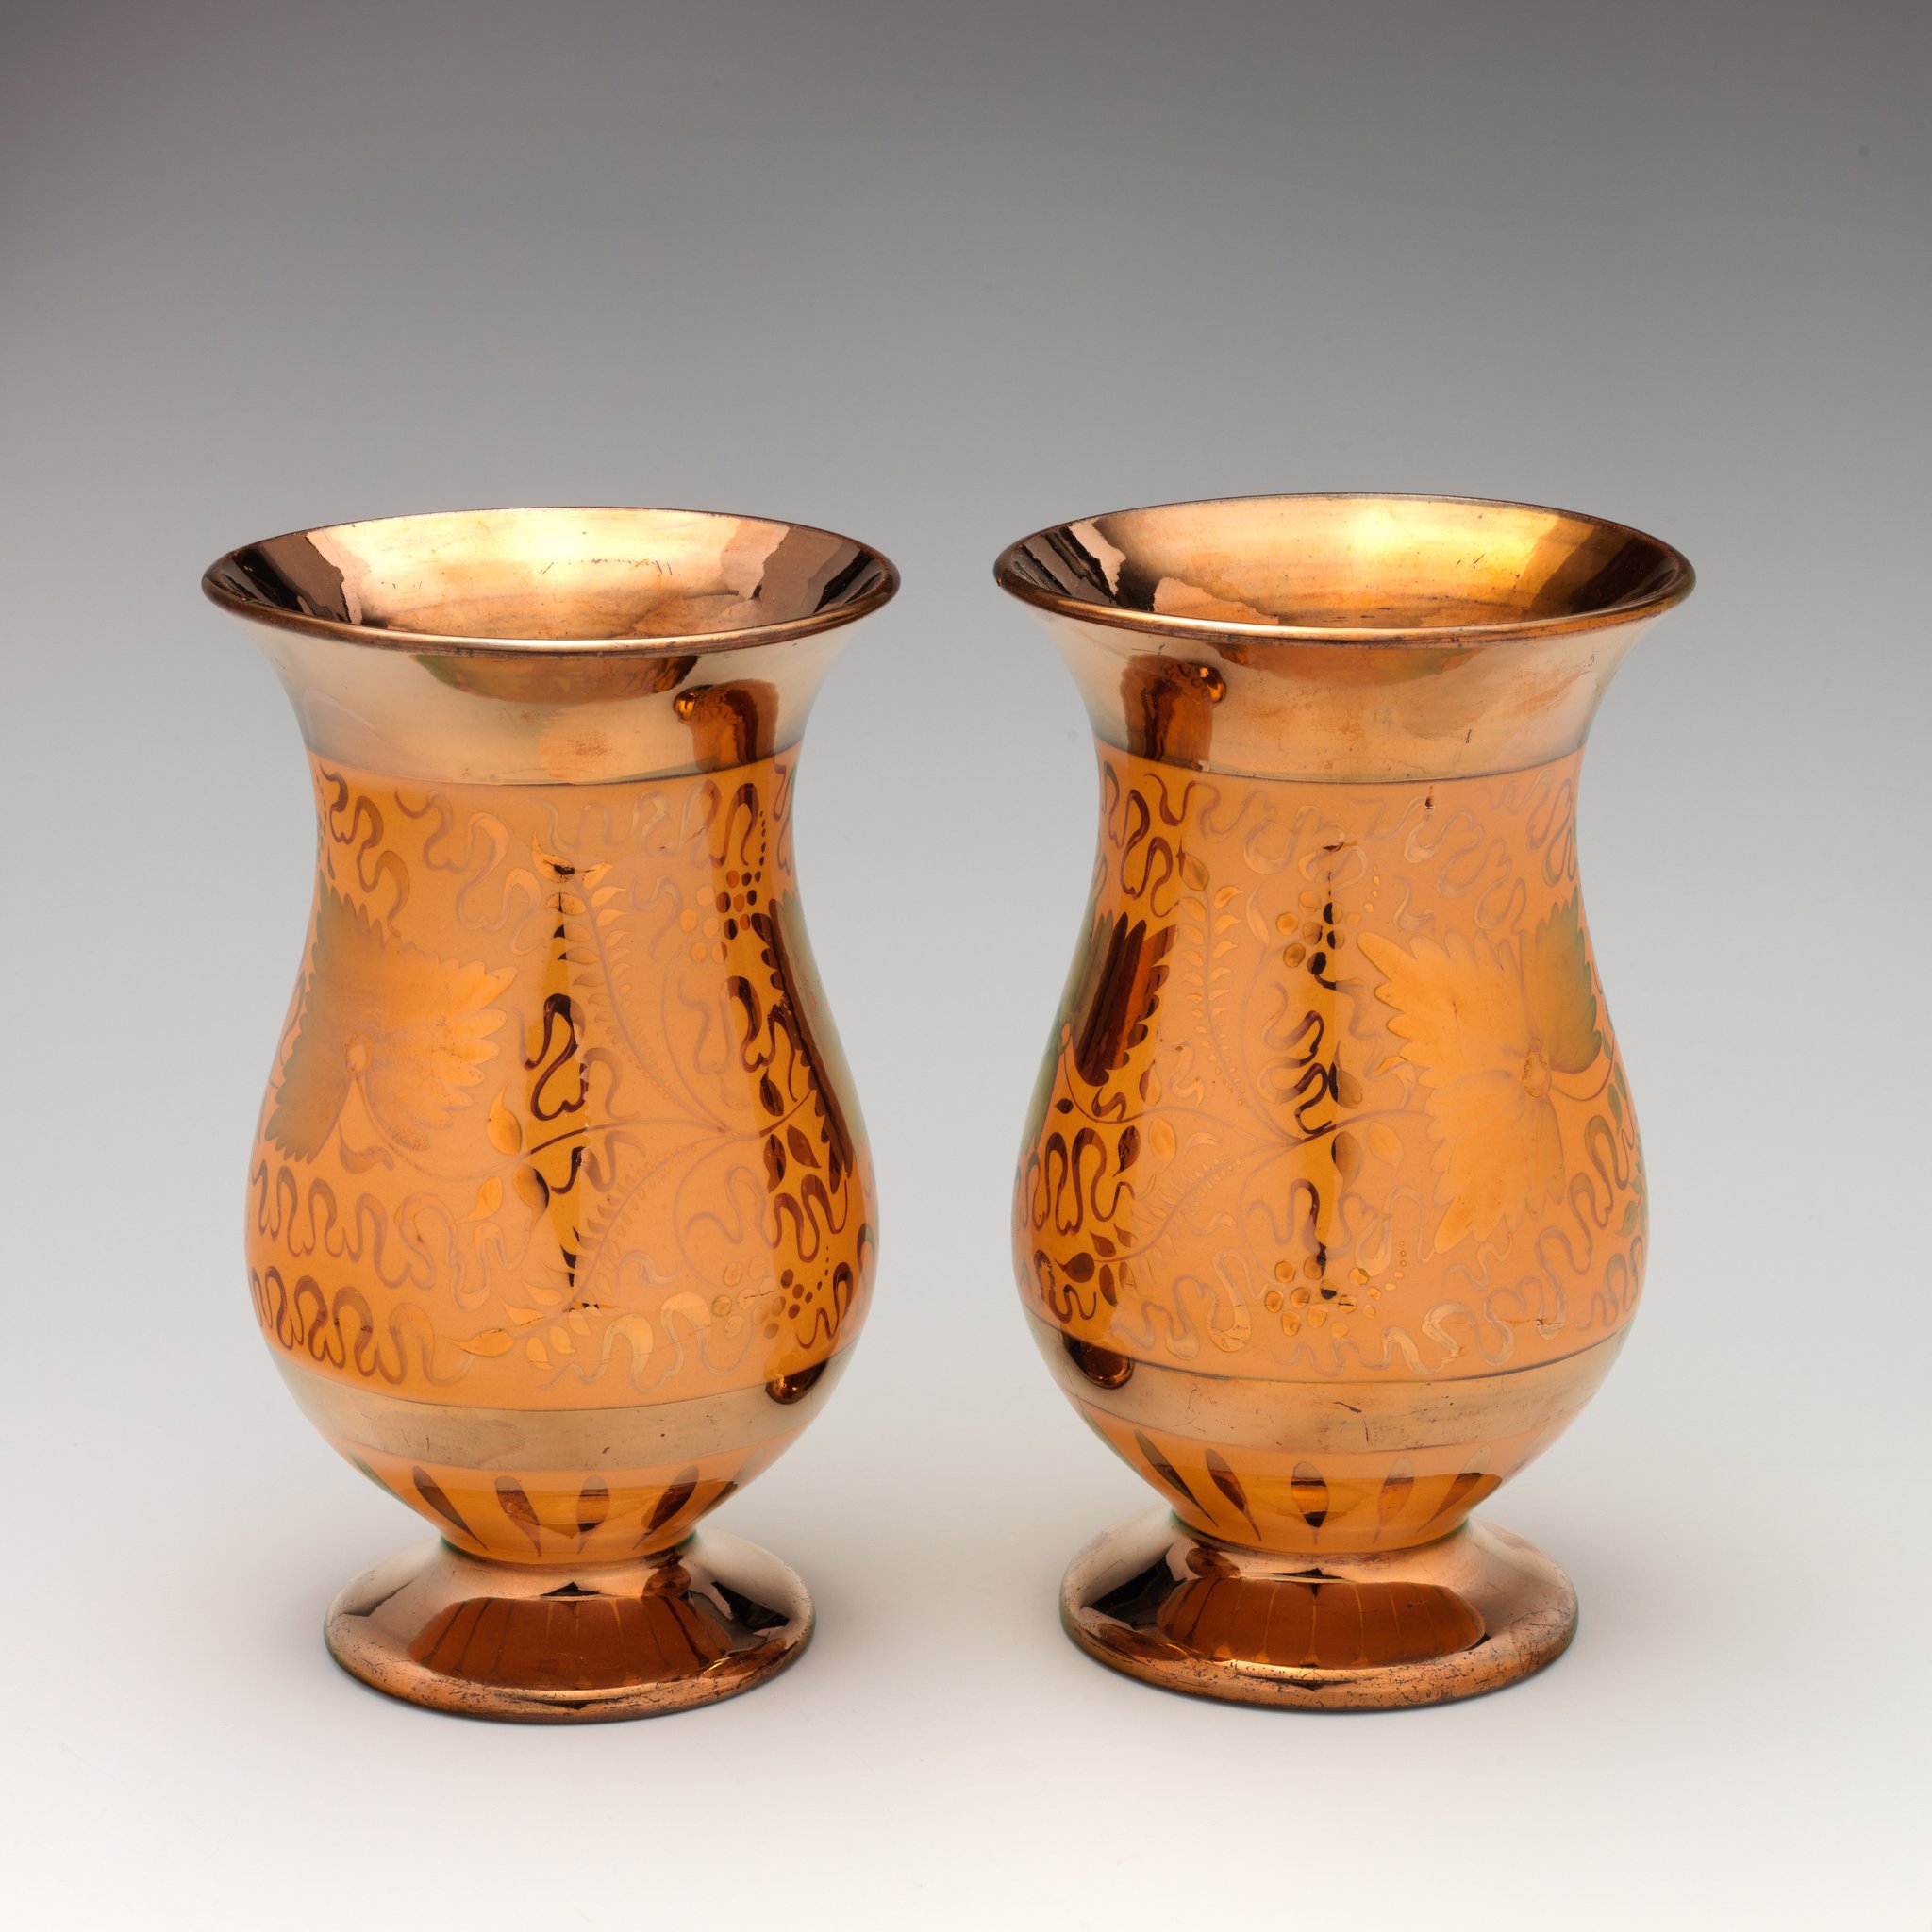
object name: vase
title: Pair of vases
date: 1801-1900